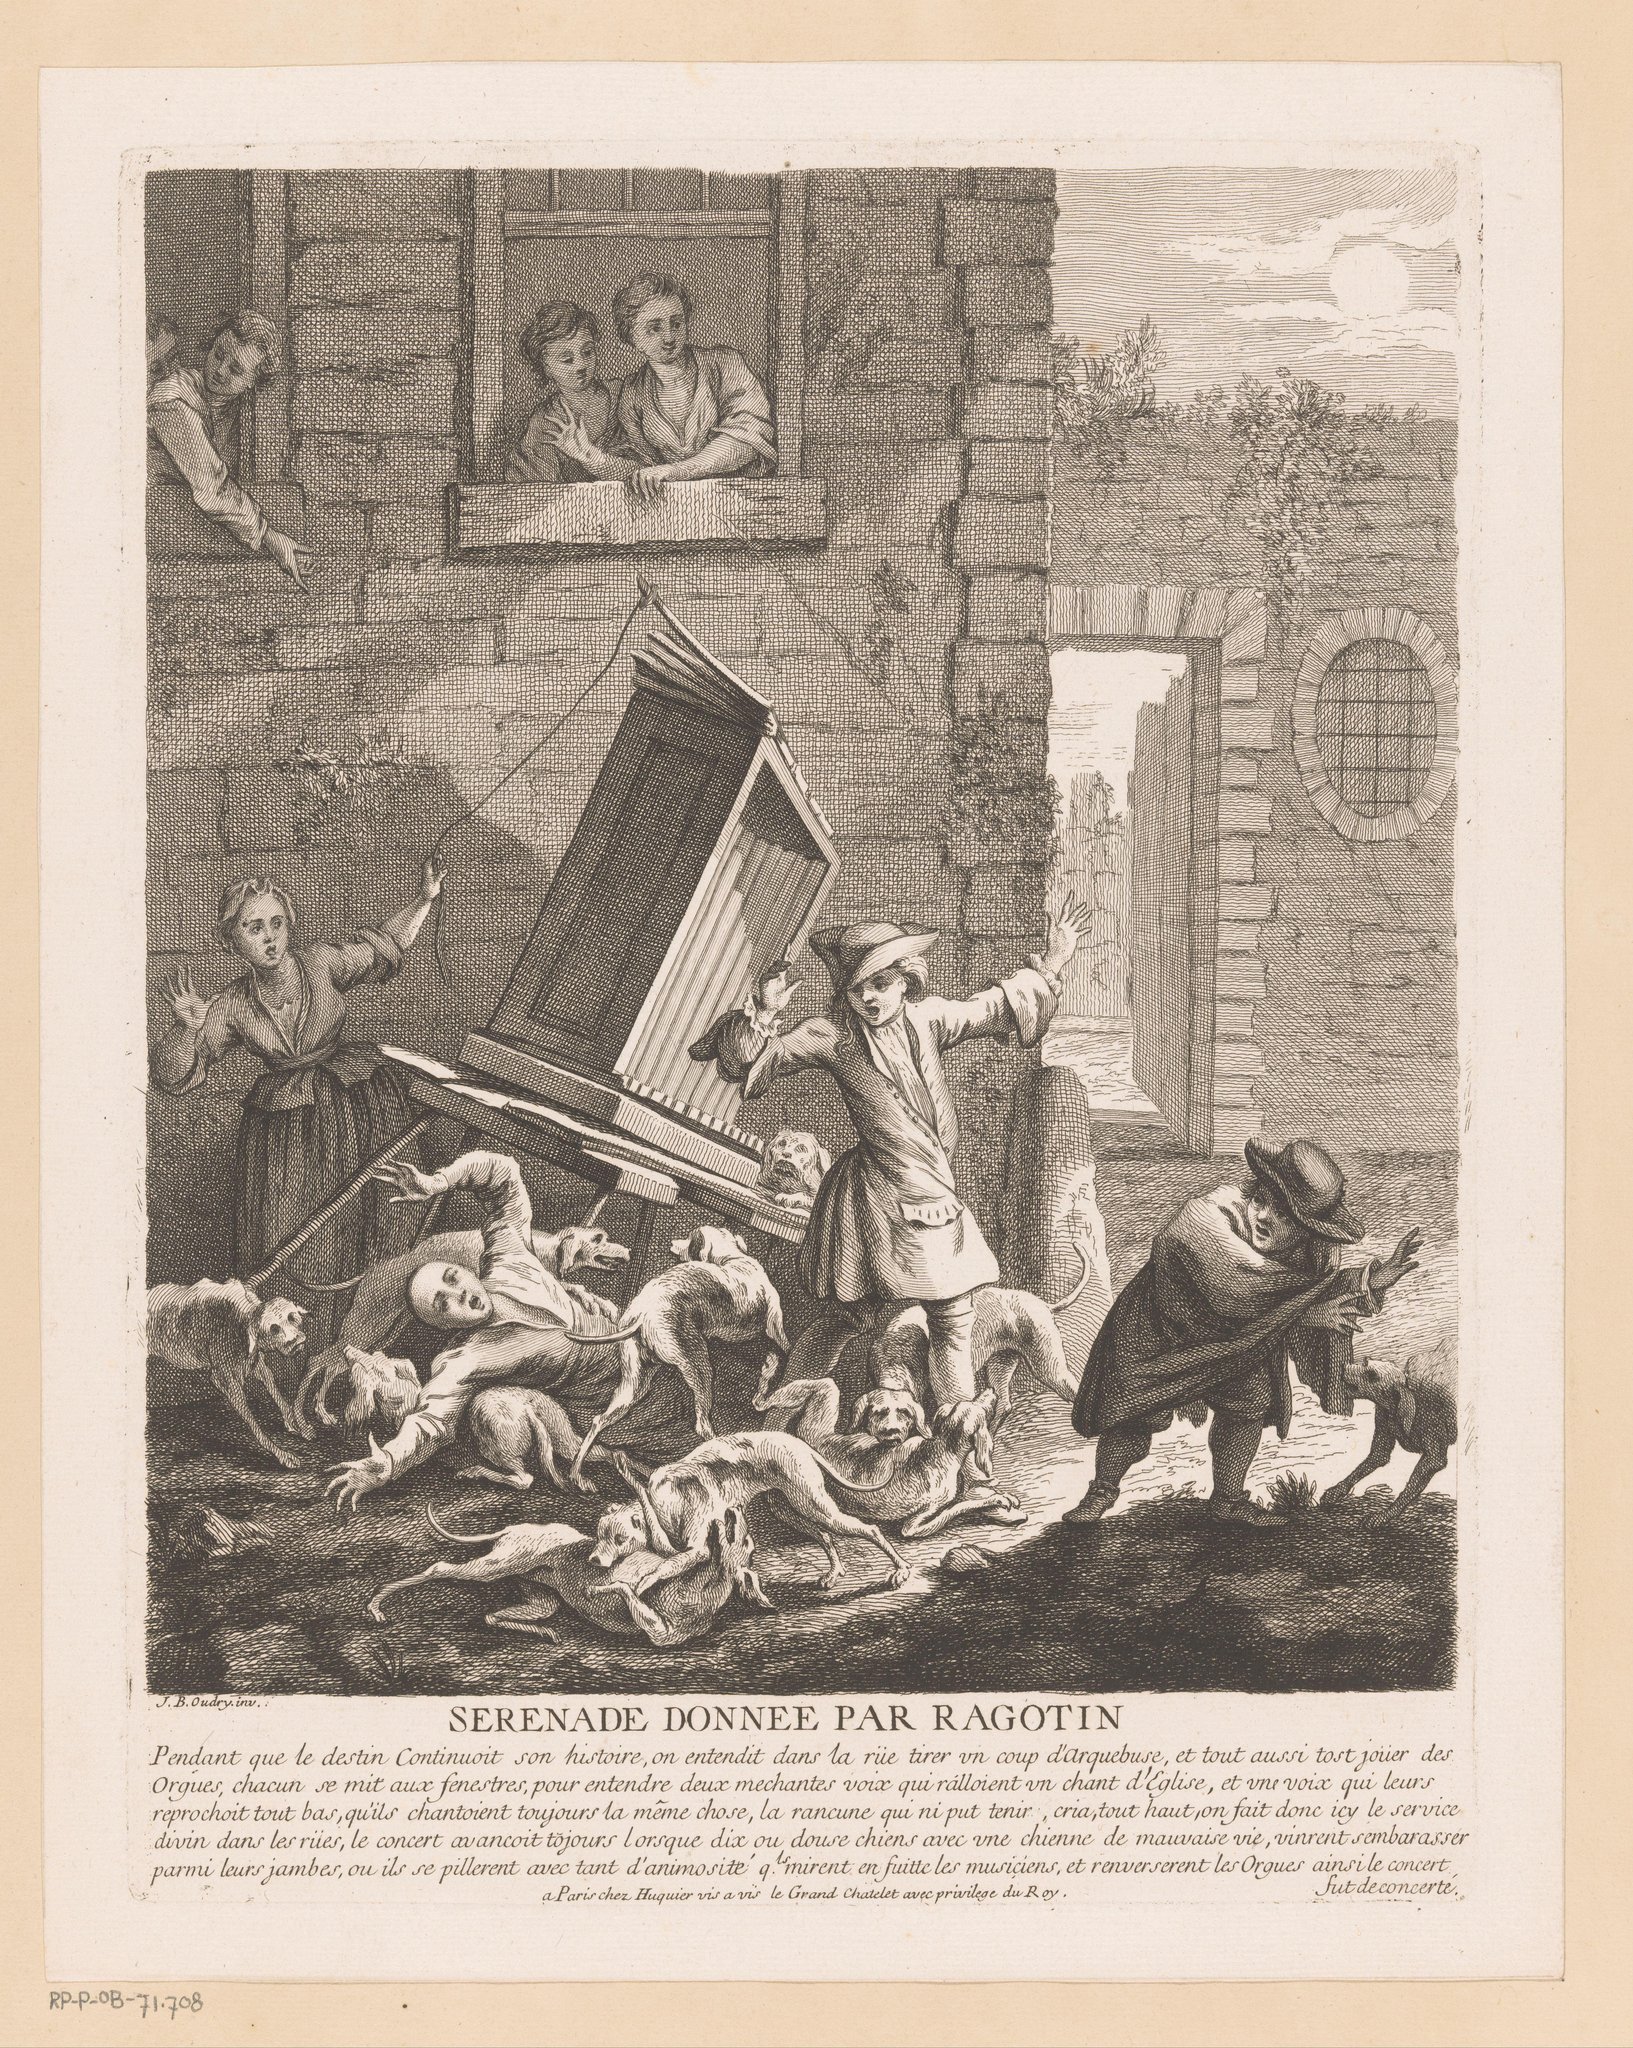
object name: print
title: Serenade donnée par Ragotin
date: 1705-1772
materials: paper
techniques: engraving, etching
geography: france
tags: (scarron, roman comique) specific works of literature (with author, title), organ, dog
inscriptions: collector's mark: Lugt 240